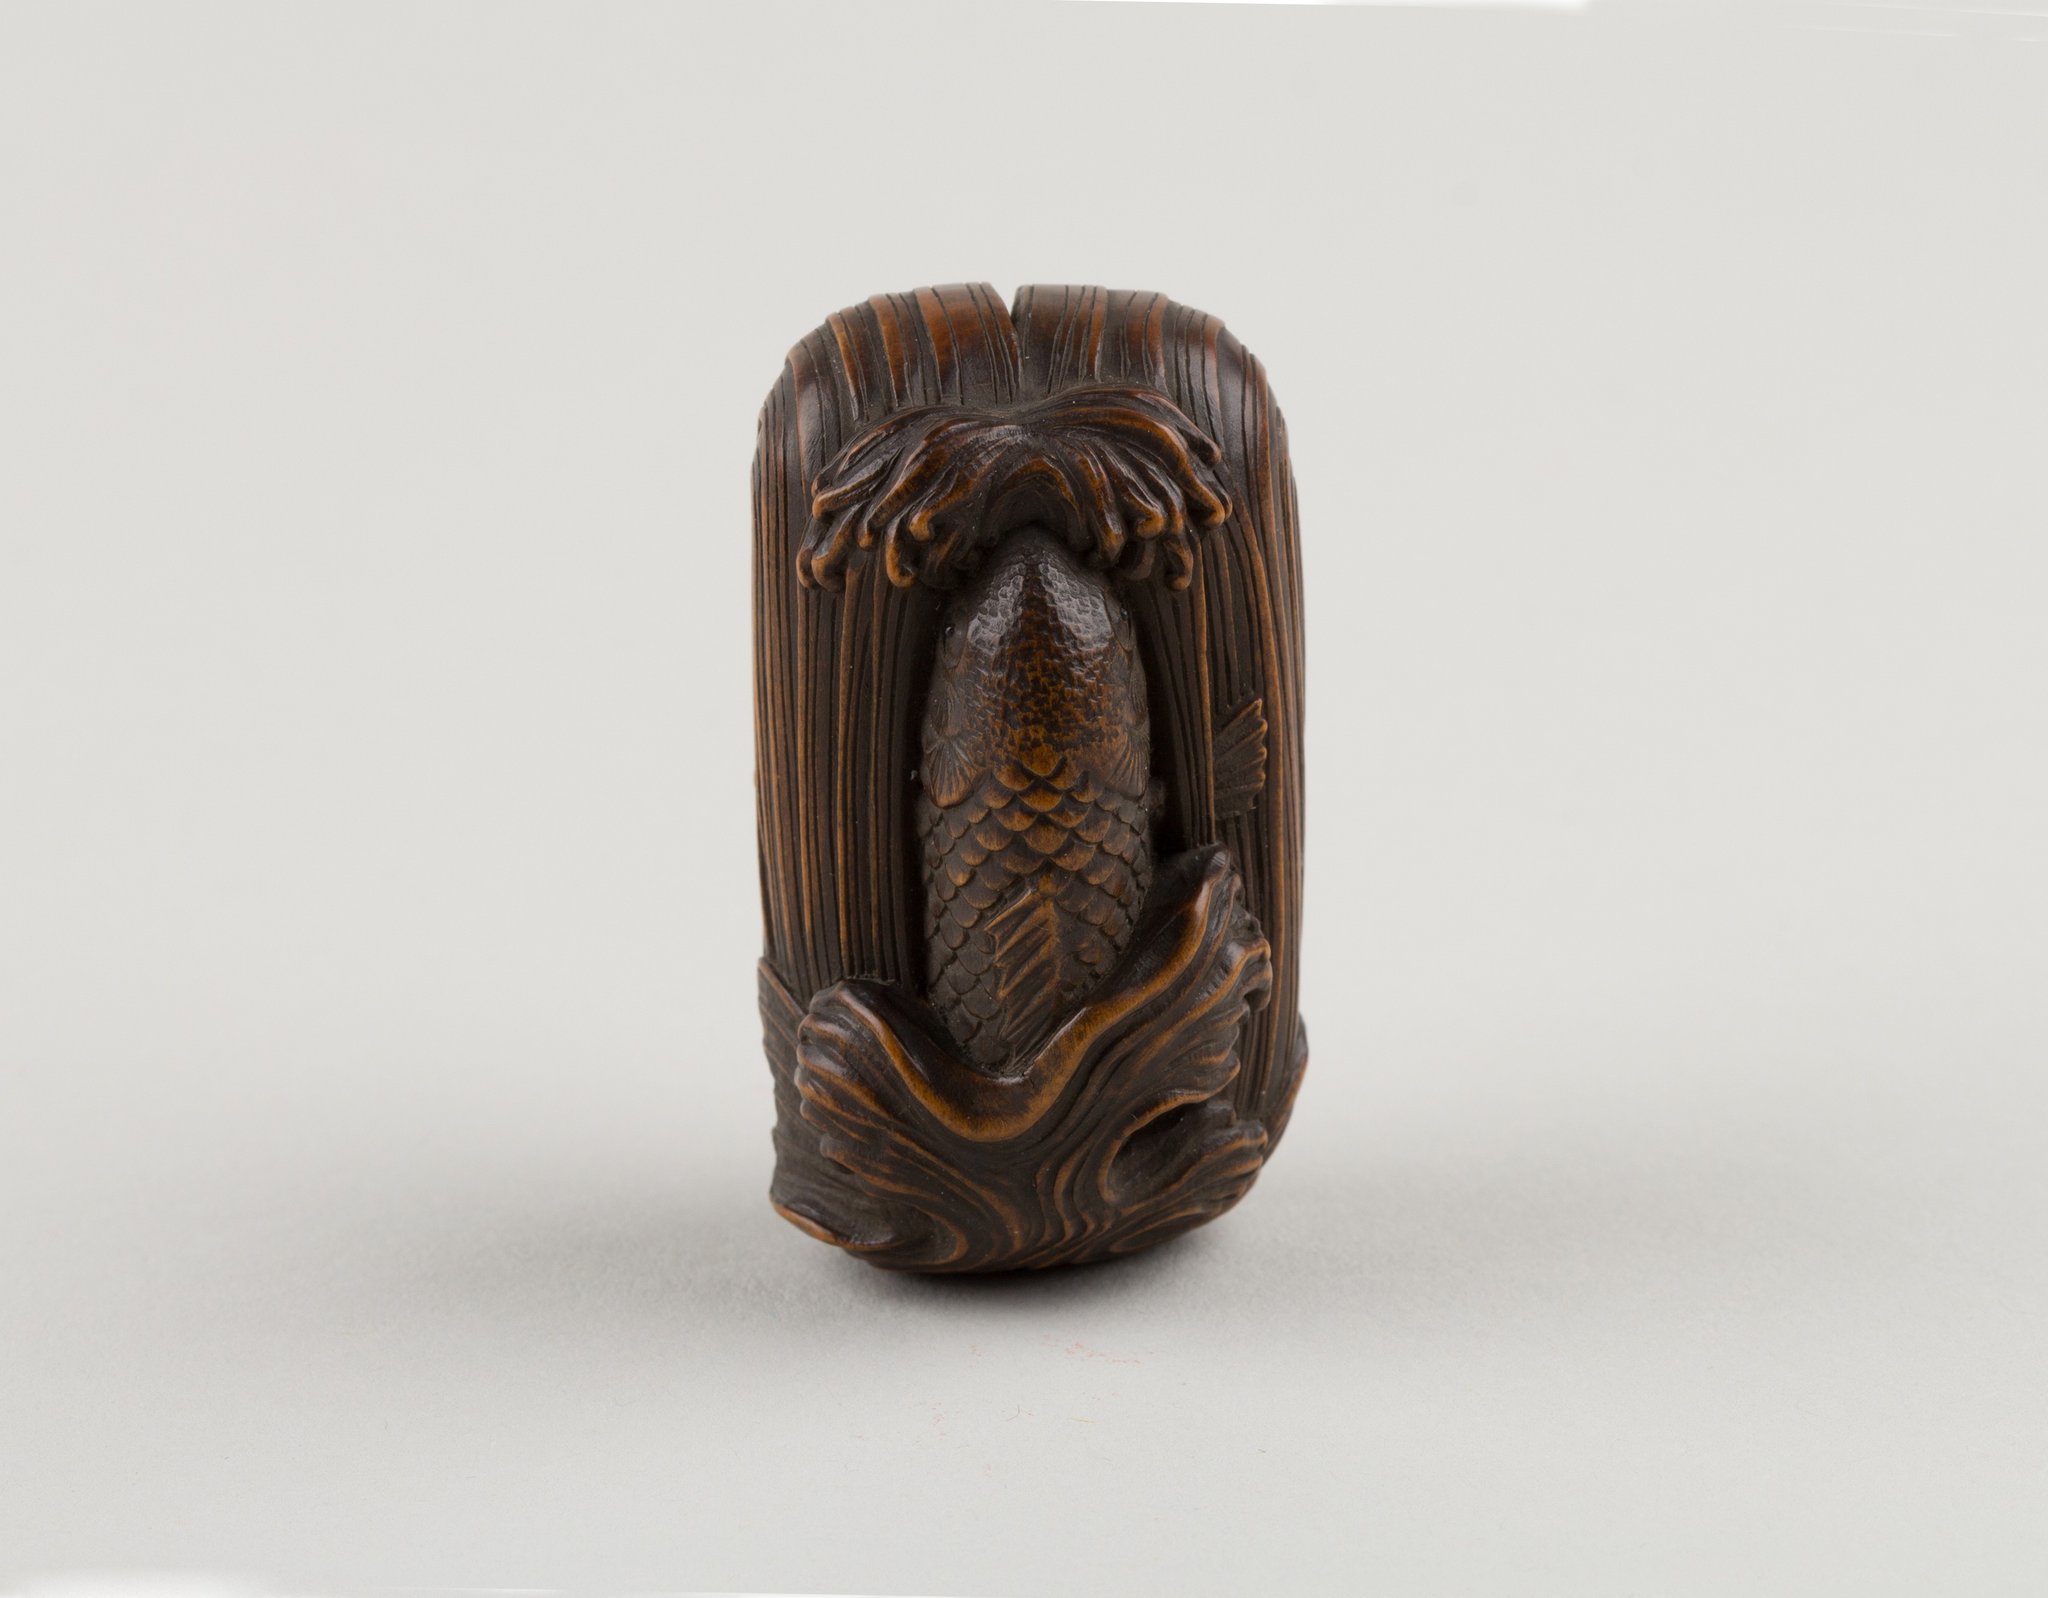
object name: netsuke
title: Netsuke of a Carp Climbing a Waterfall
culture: japanese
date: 1801-1900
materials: wood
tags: fish,waterfalls